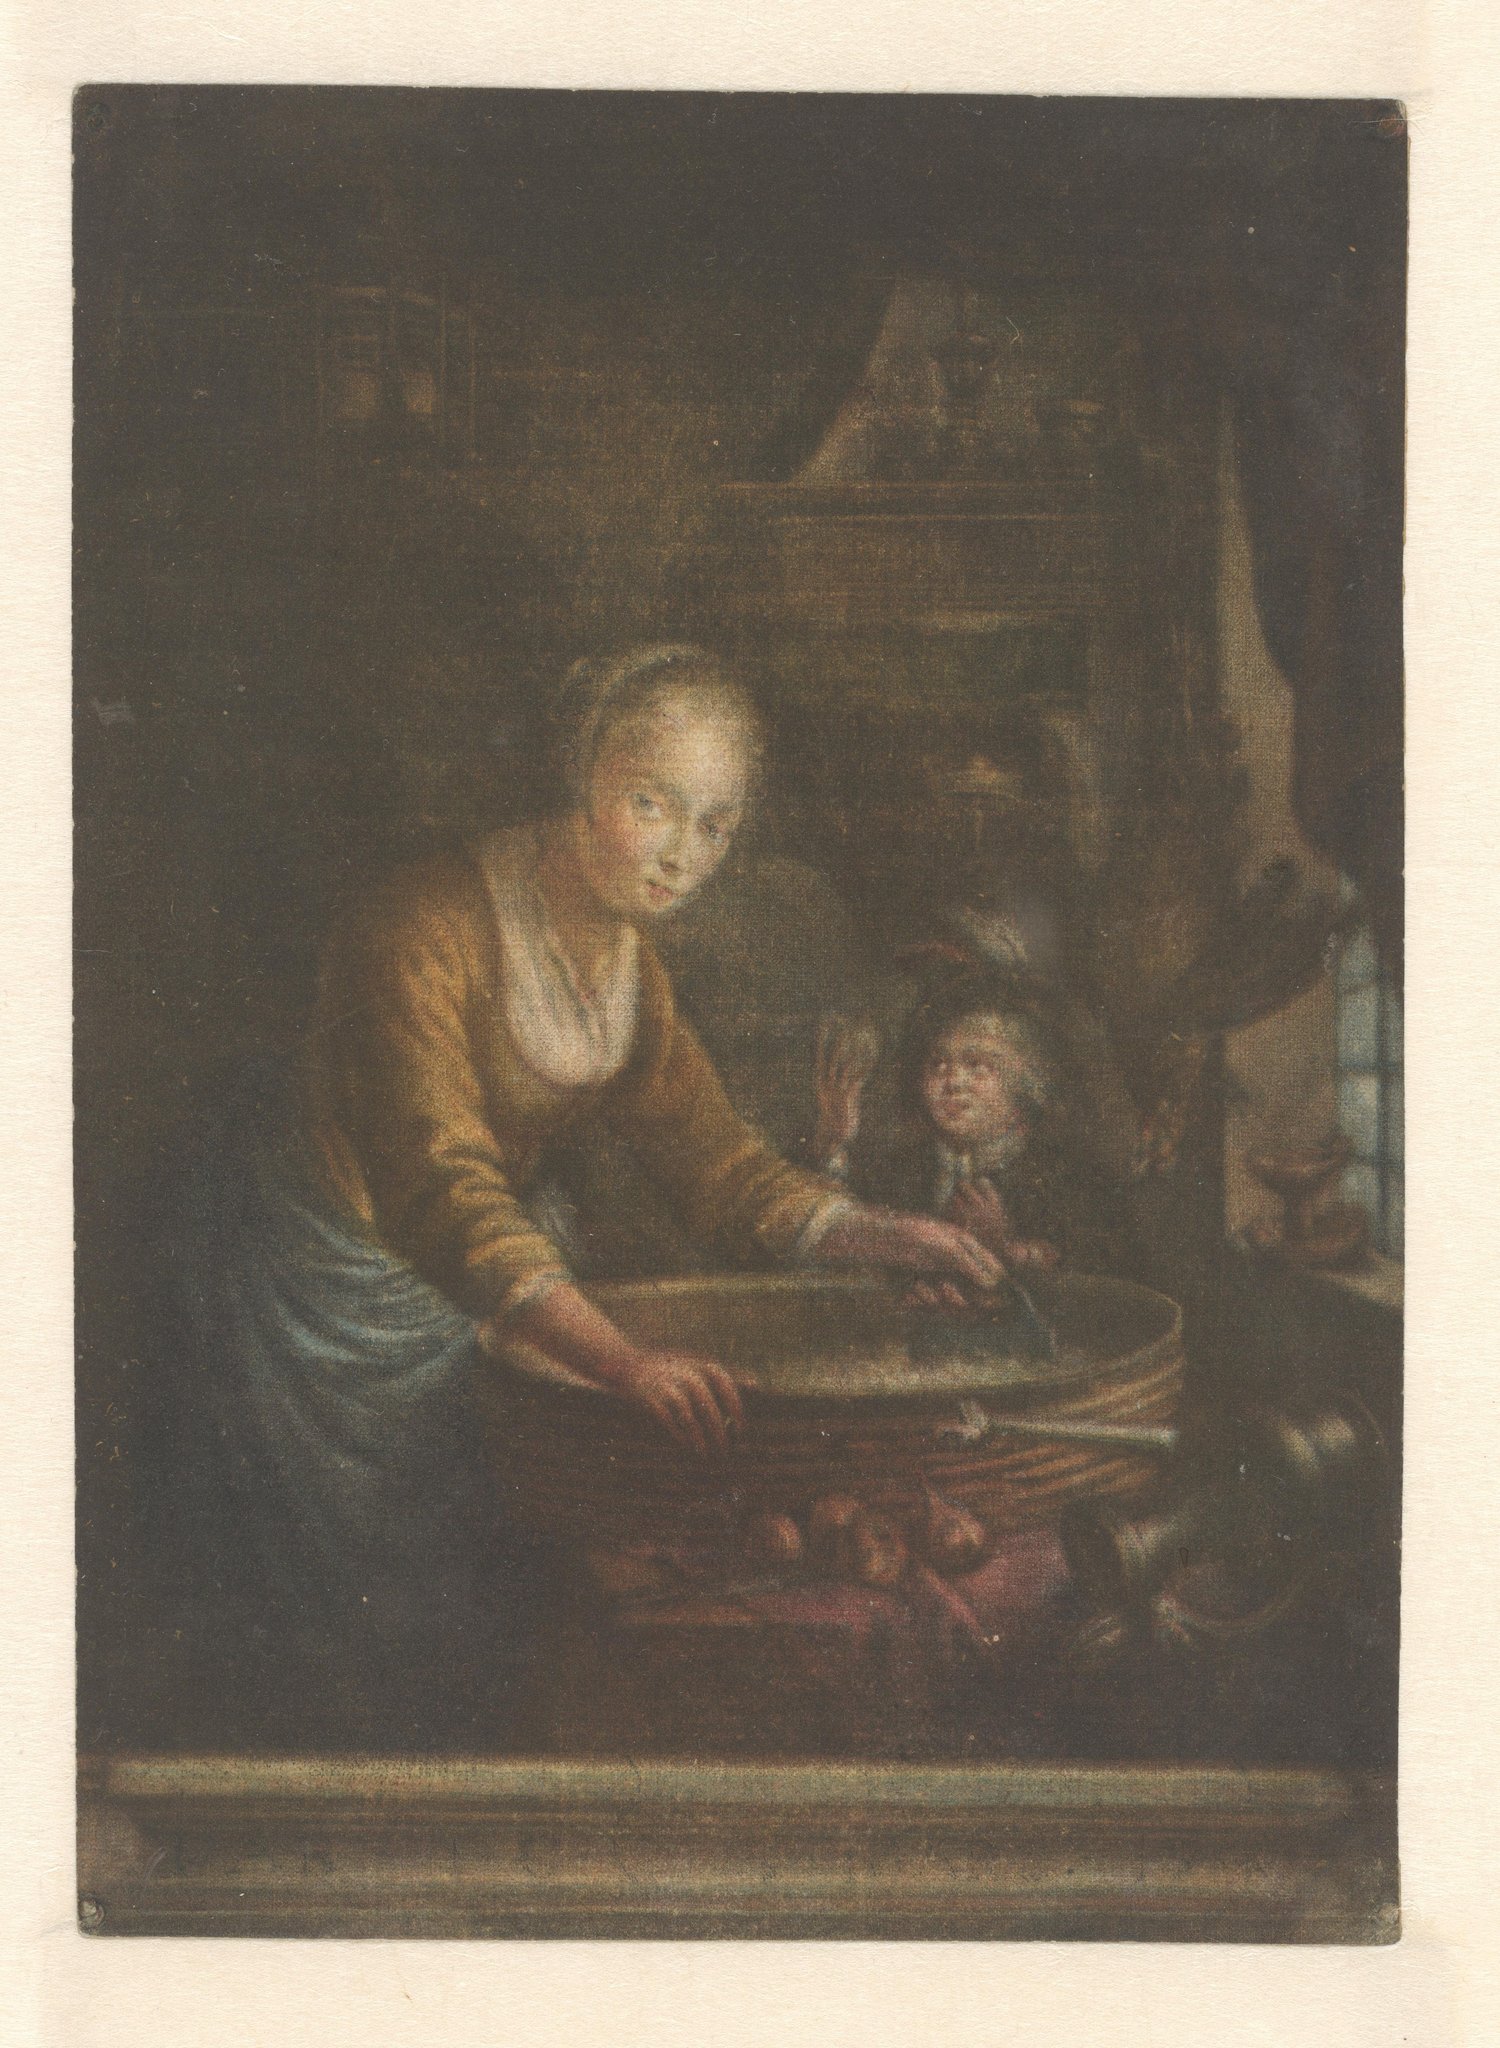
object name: print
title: Jonge vrouw, uien hakkend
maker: jacques fabien gautier dagoty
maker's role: painter, print maker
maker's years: 1711-1781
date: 1741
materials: paper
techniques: color mezzotint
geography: france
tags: cook - cc - female cook, cooking food, kitchen-maid, kitchen servant, preparation of food